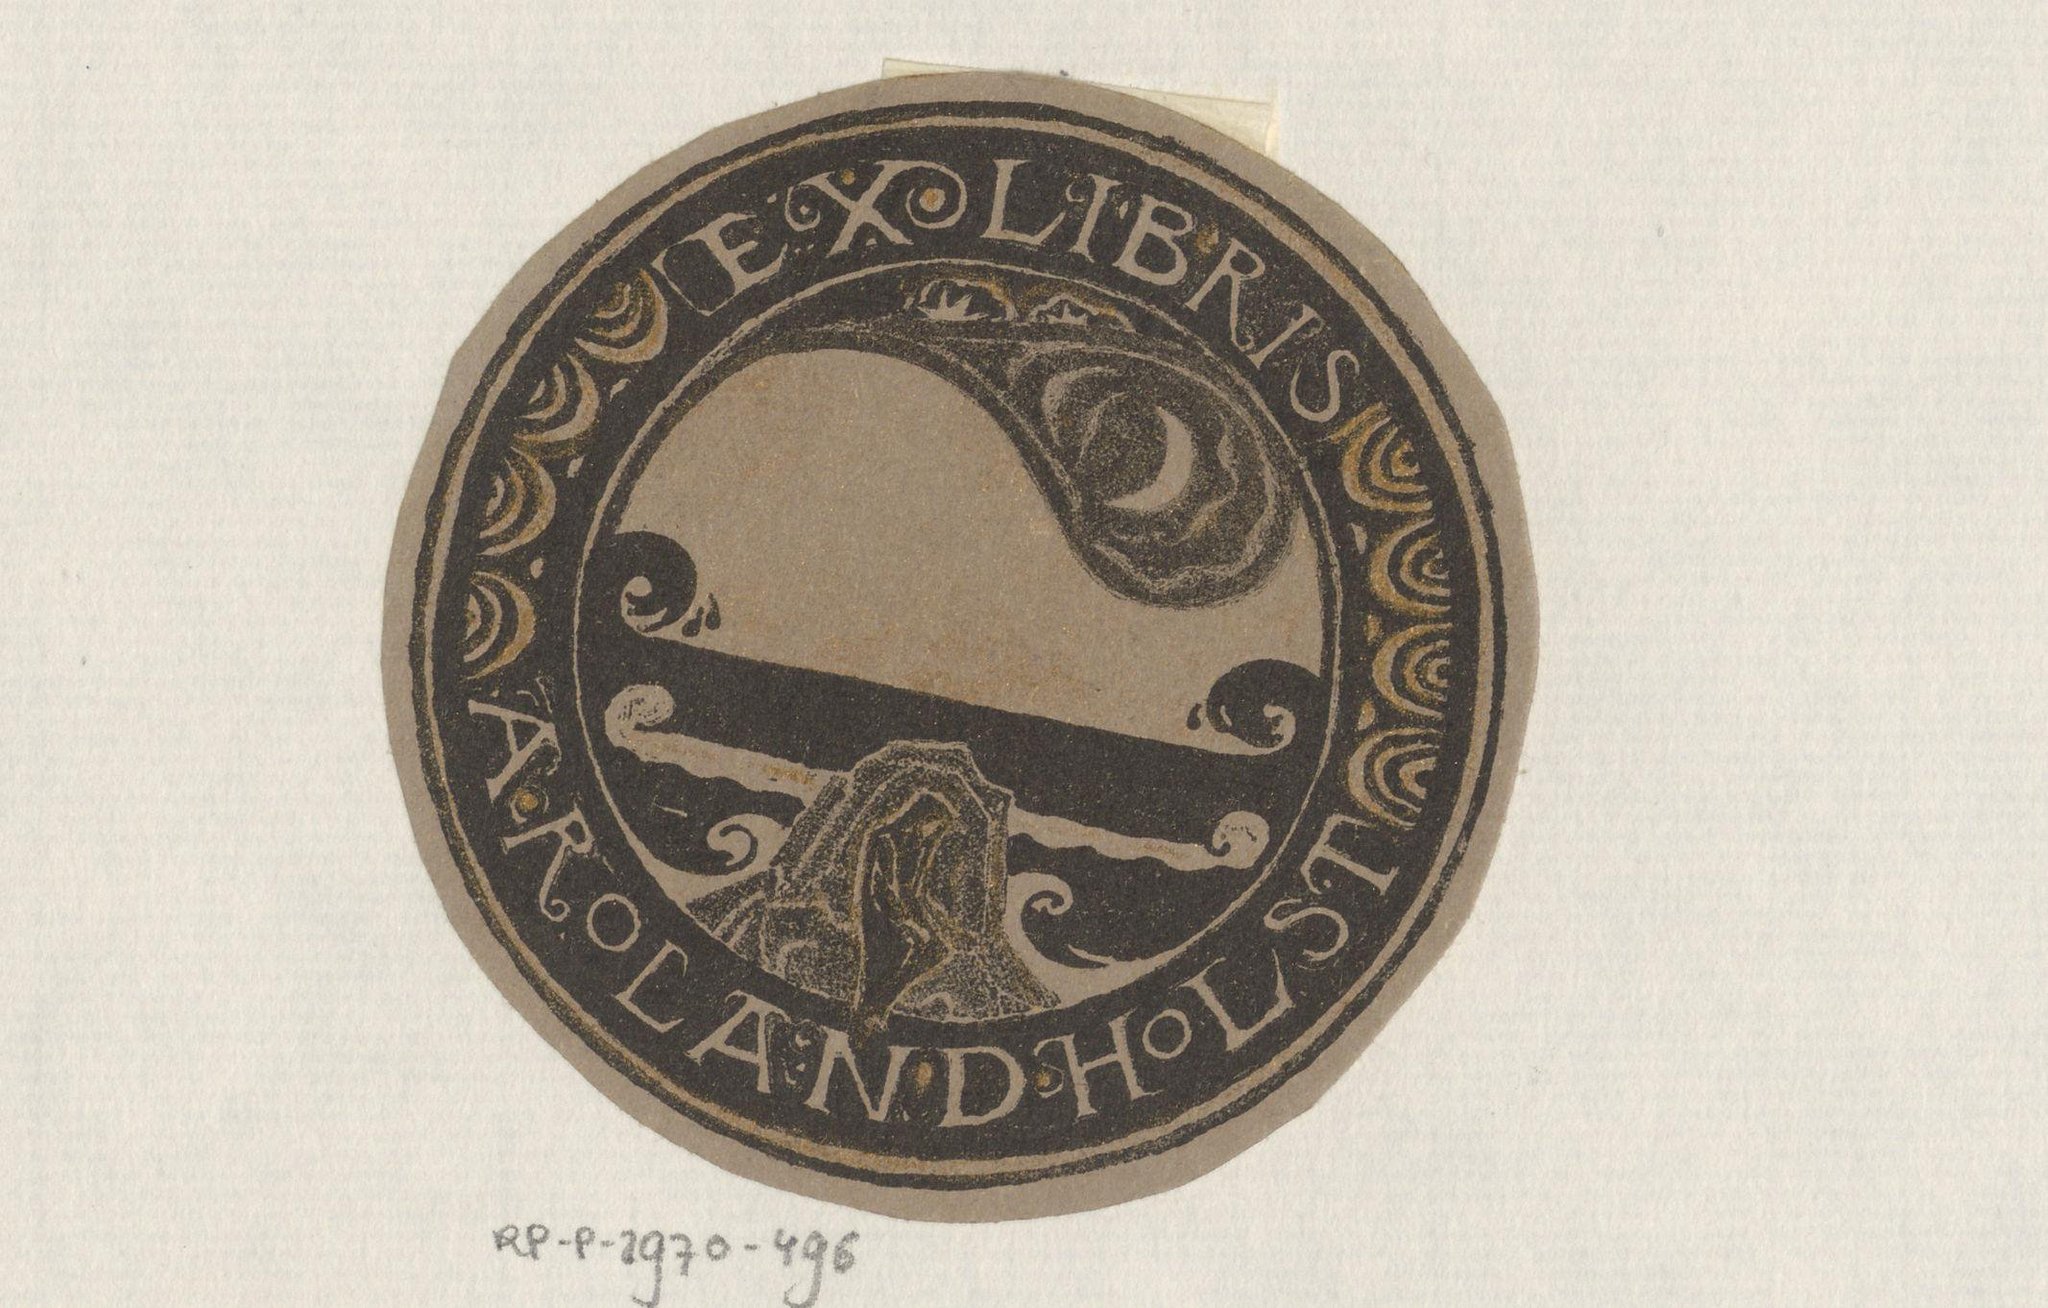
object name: bookplate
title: Ex libris van Adriaan Roland Holst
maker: richard nicolaüs roland holst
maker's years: 1868-1938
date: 1915-1916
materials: paper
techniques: lithograph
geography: netherlands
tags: adriaan roland holst, sitting on an elevation, rocks, sea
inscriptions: collector's mark: Lugt 2228